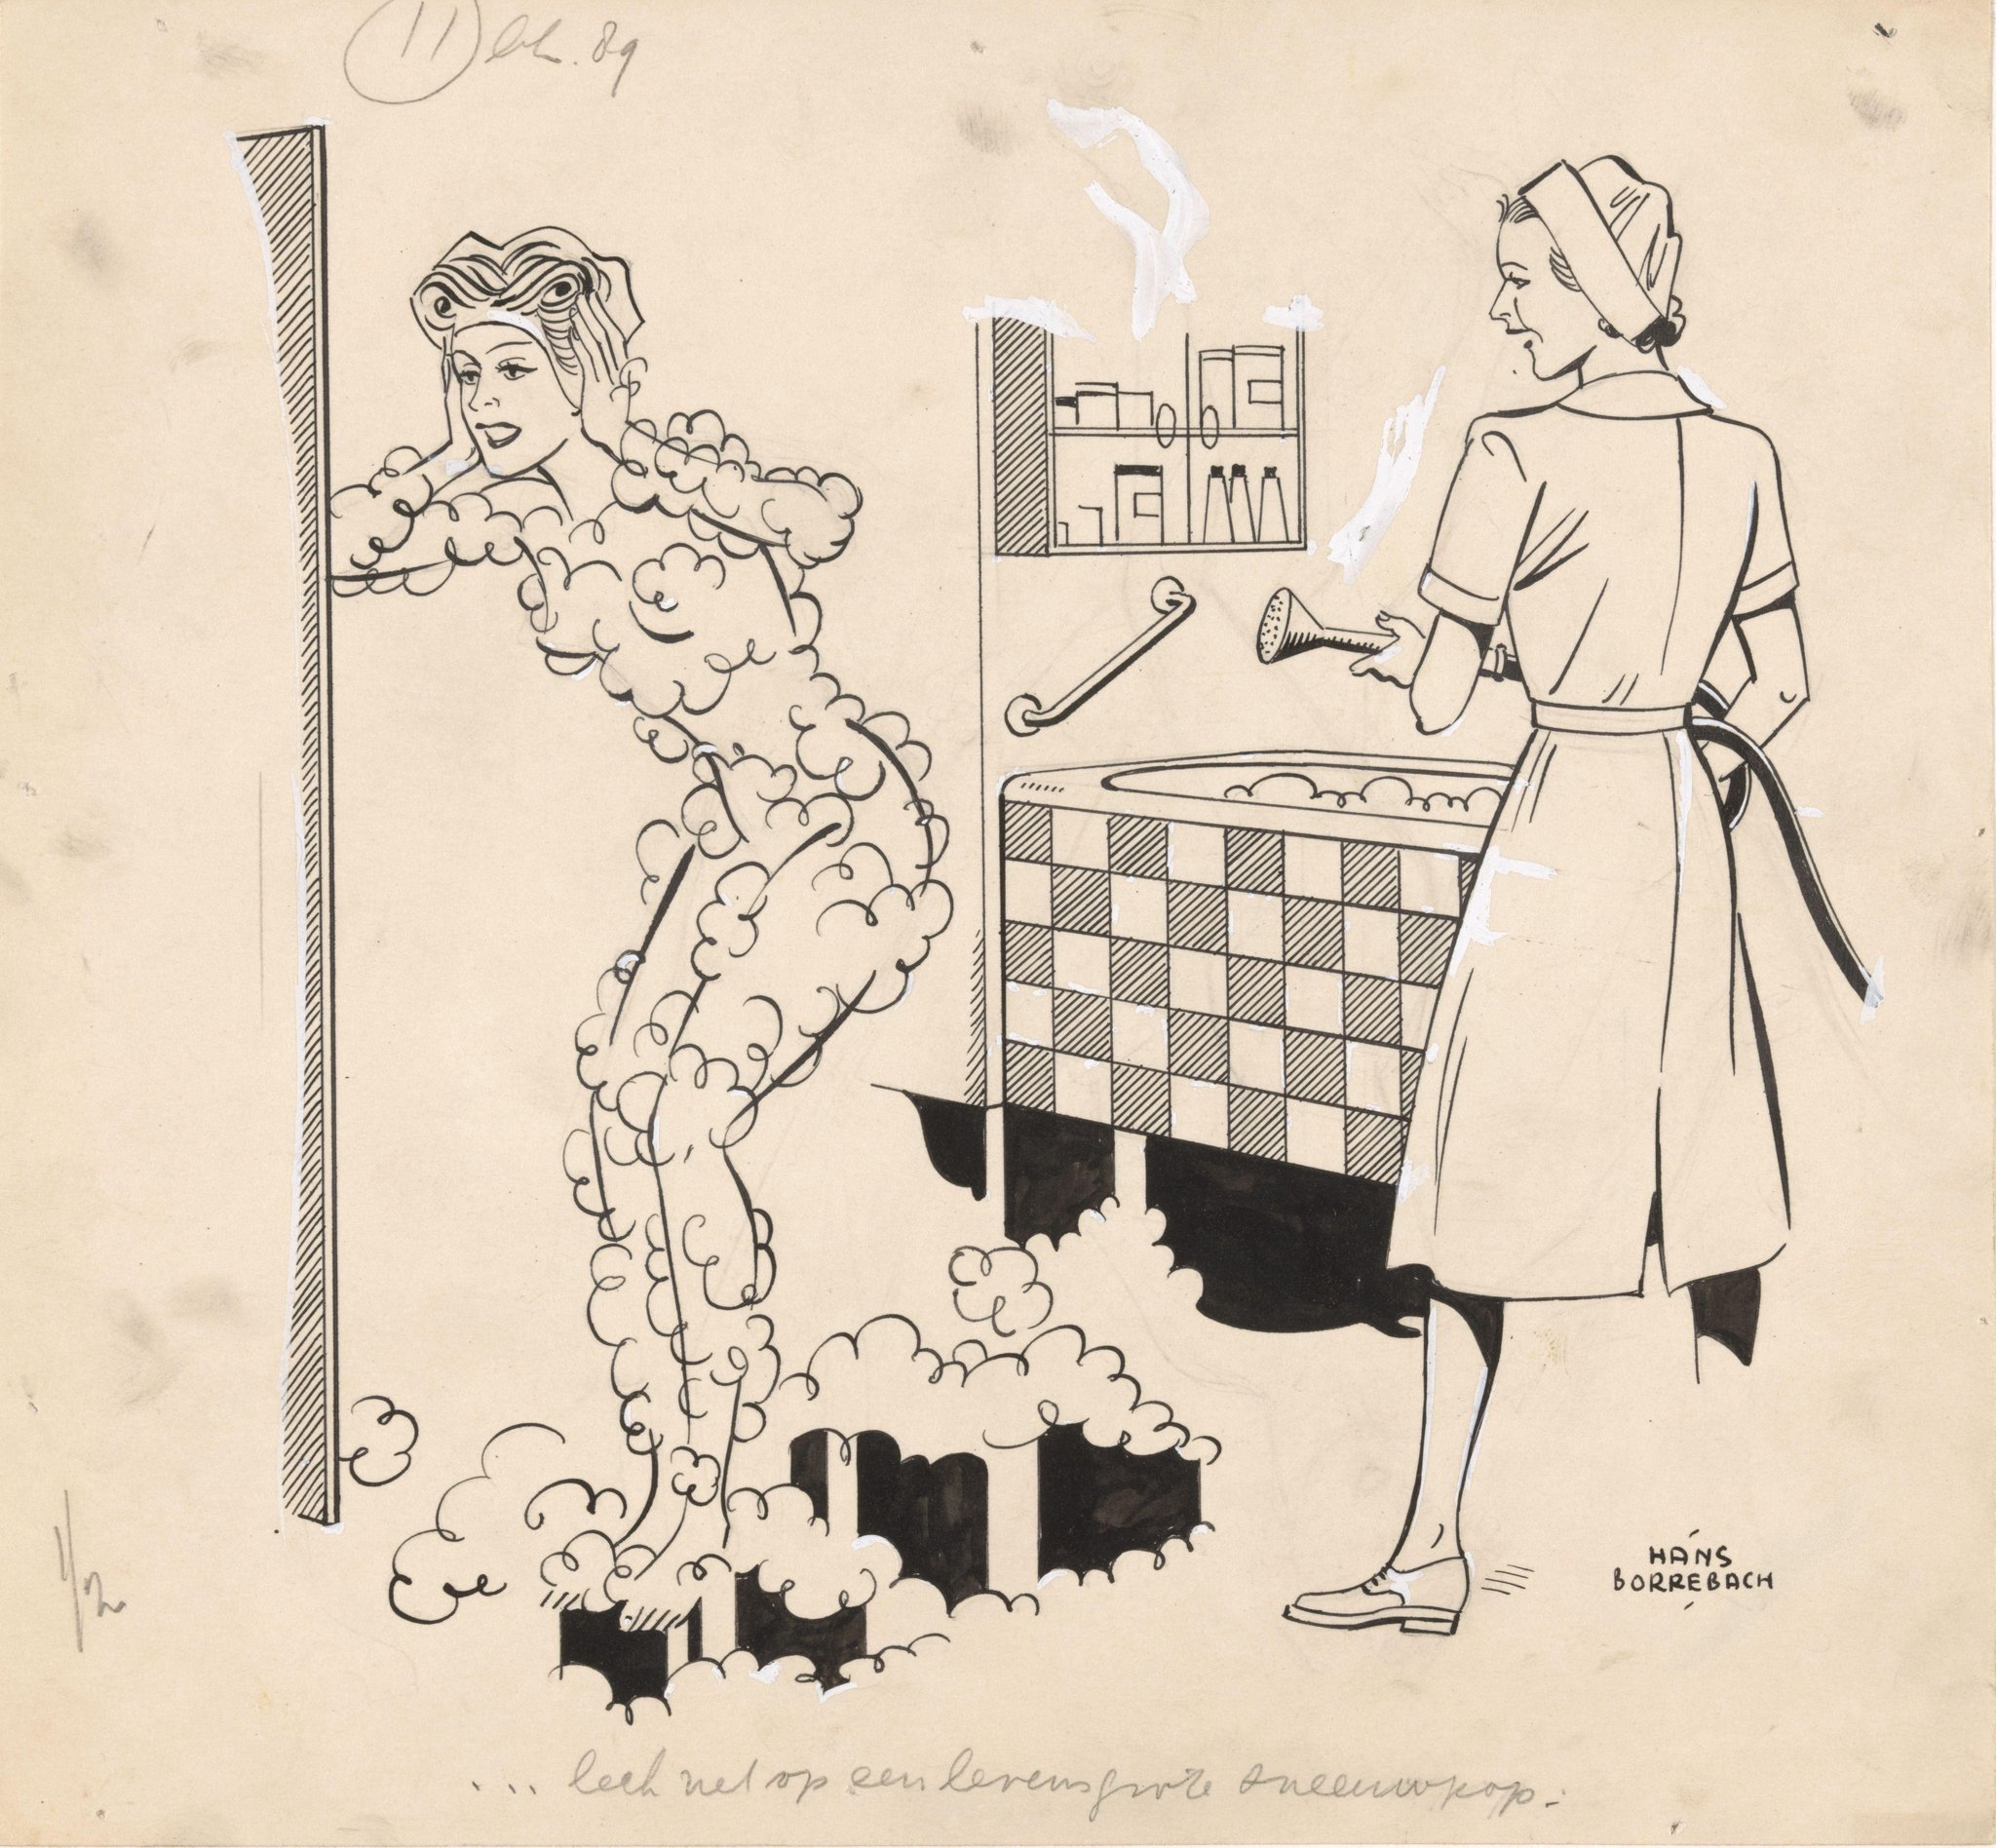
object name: boekillustratie ontwerp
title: Pepita neemt een schuimdouche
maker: hans borrebach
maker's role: draughtsman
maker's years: 1903-1991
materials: paint, ink, paper, pencil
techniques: brush, pen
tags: shower, soap-bubble, the (nude) human figure; 'corpo humano' (ripa) - aa - female human figure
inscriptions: collector's mark: Lugt 2228a, annotation: ‘11 blz 89/ ... leek net op een levensgrote sneeuwpop’, :, signature: ‘HANS./ BORREBACH’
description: In een badkamer staat Pepita onder de douche. Ze heeft haar lichaam ingezeept met sop. Een vrouw houdt een douchekop vast om haar af te spoelen.